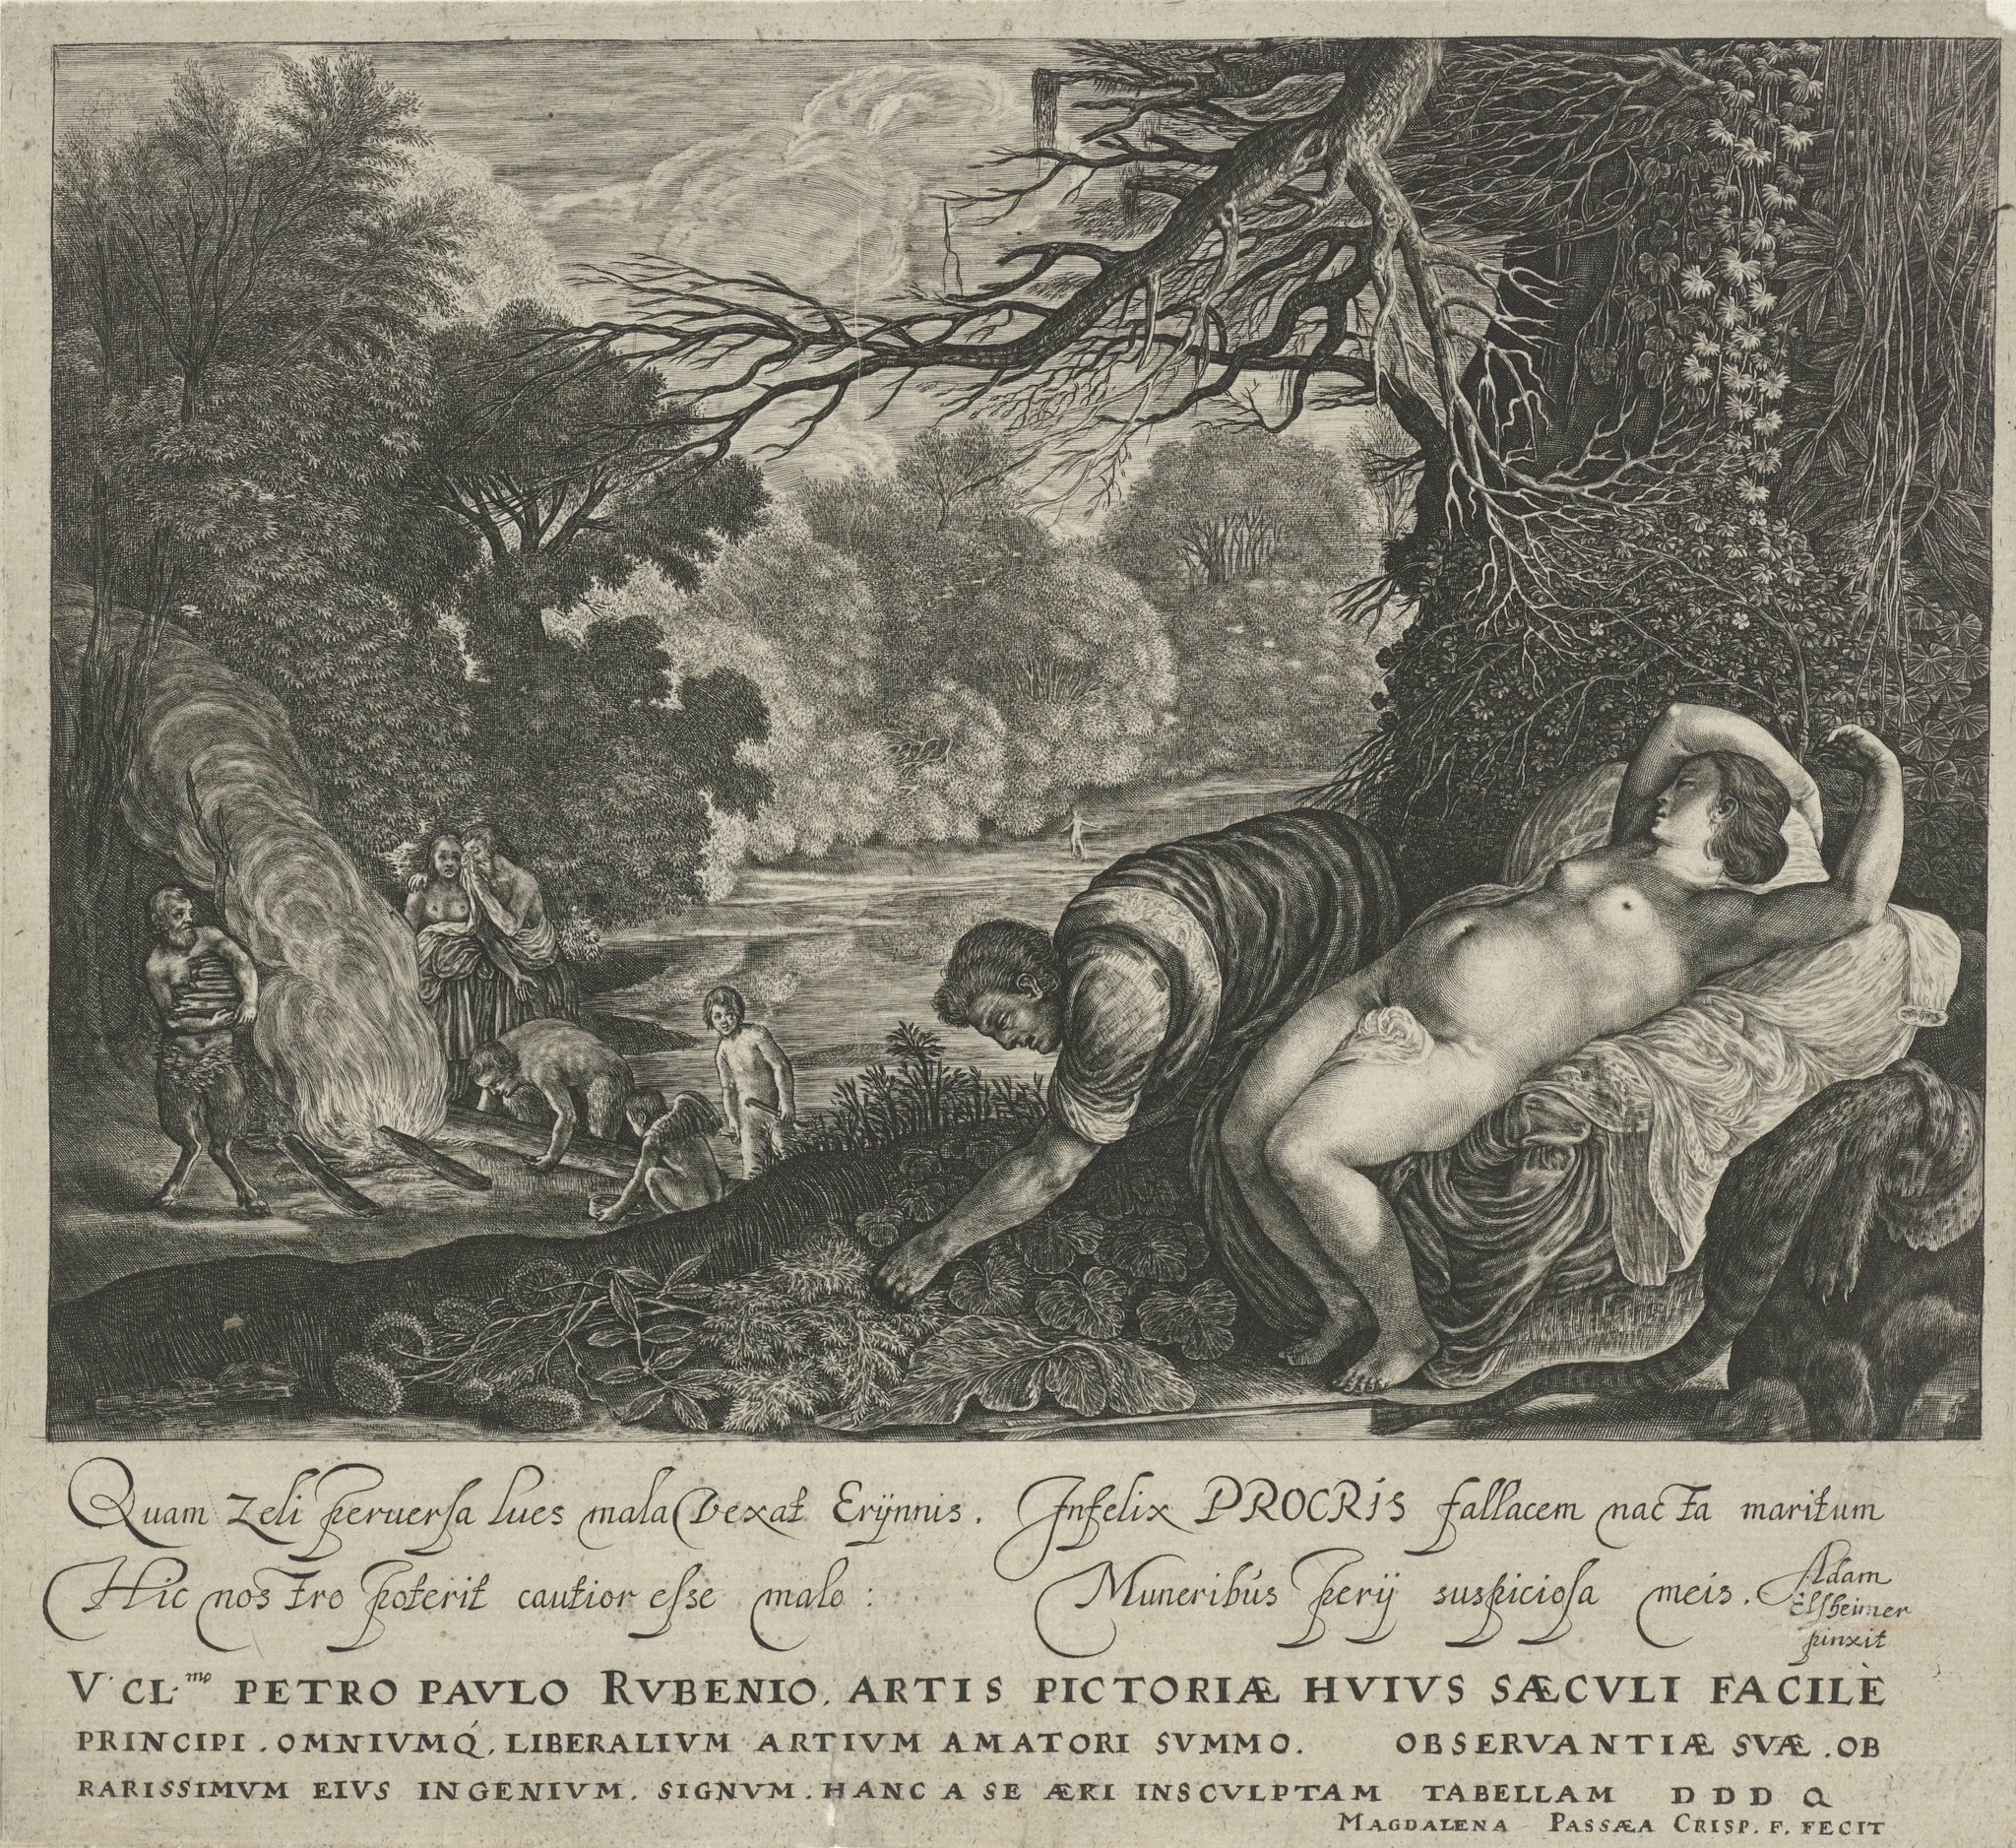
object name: print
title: Cephalus en Procris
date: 1617-1634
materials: paper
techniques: engraving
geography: utrecht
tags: cephalus inadvertently kills procris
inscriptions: collector's mark: Lugt 1904, collector's mark: Lugt 2760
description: Boslandschap met Cephalus die per ongeluk zijn echtgenote Procris heeft neergeschoten tijdens de jacht. Cephalus heeft haar zojuist gevonden en zoekt naar kruiden om haar wond mee te genezen. Op de achtergrond treurende figuren en de faun die Procris vertelde dat haar echtgenoot een geheime minnares zou hebben. In de marge een vierregelig onderschrift, in twee kolommen, in het Latijn.